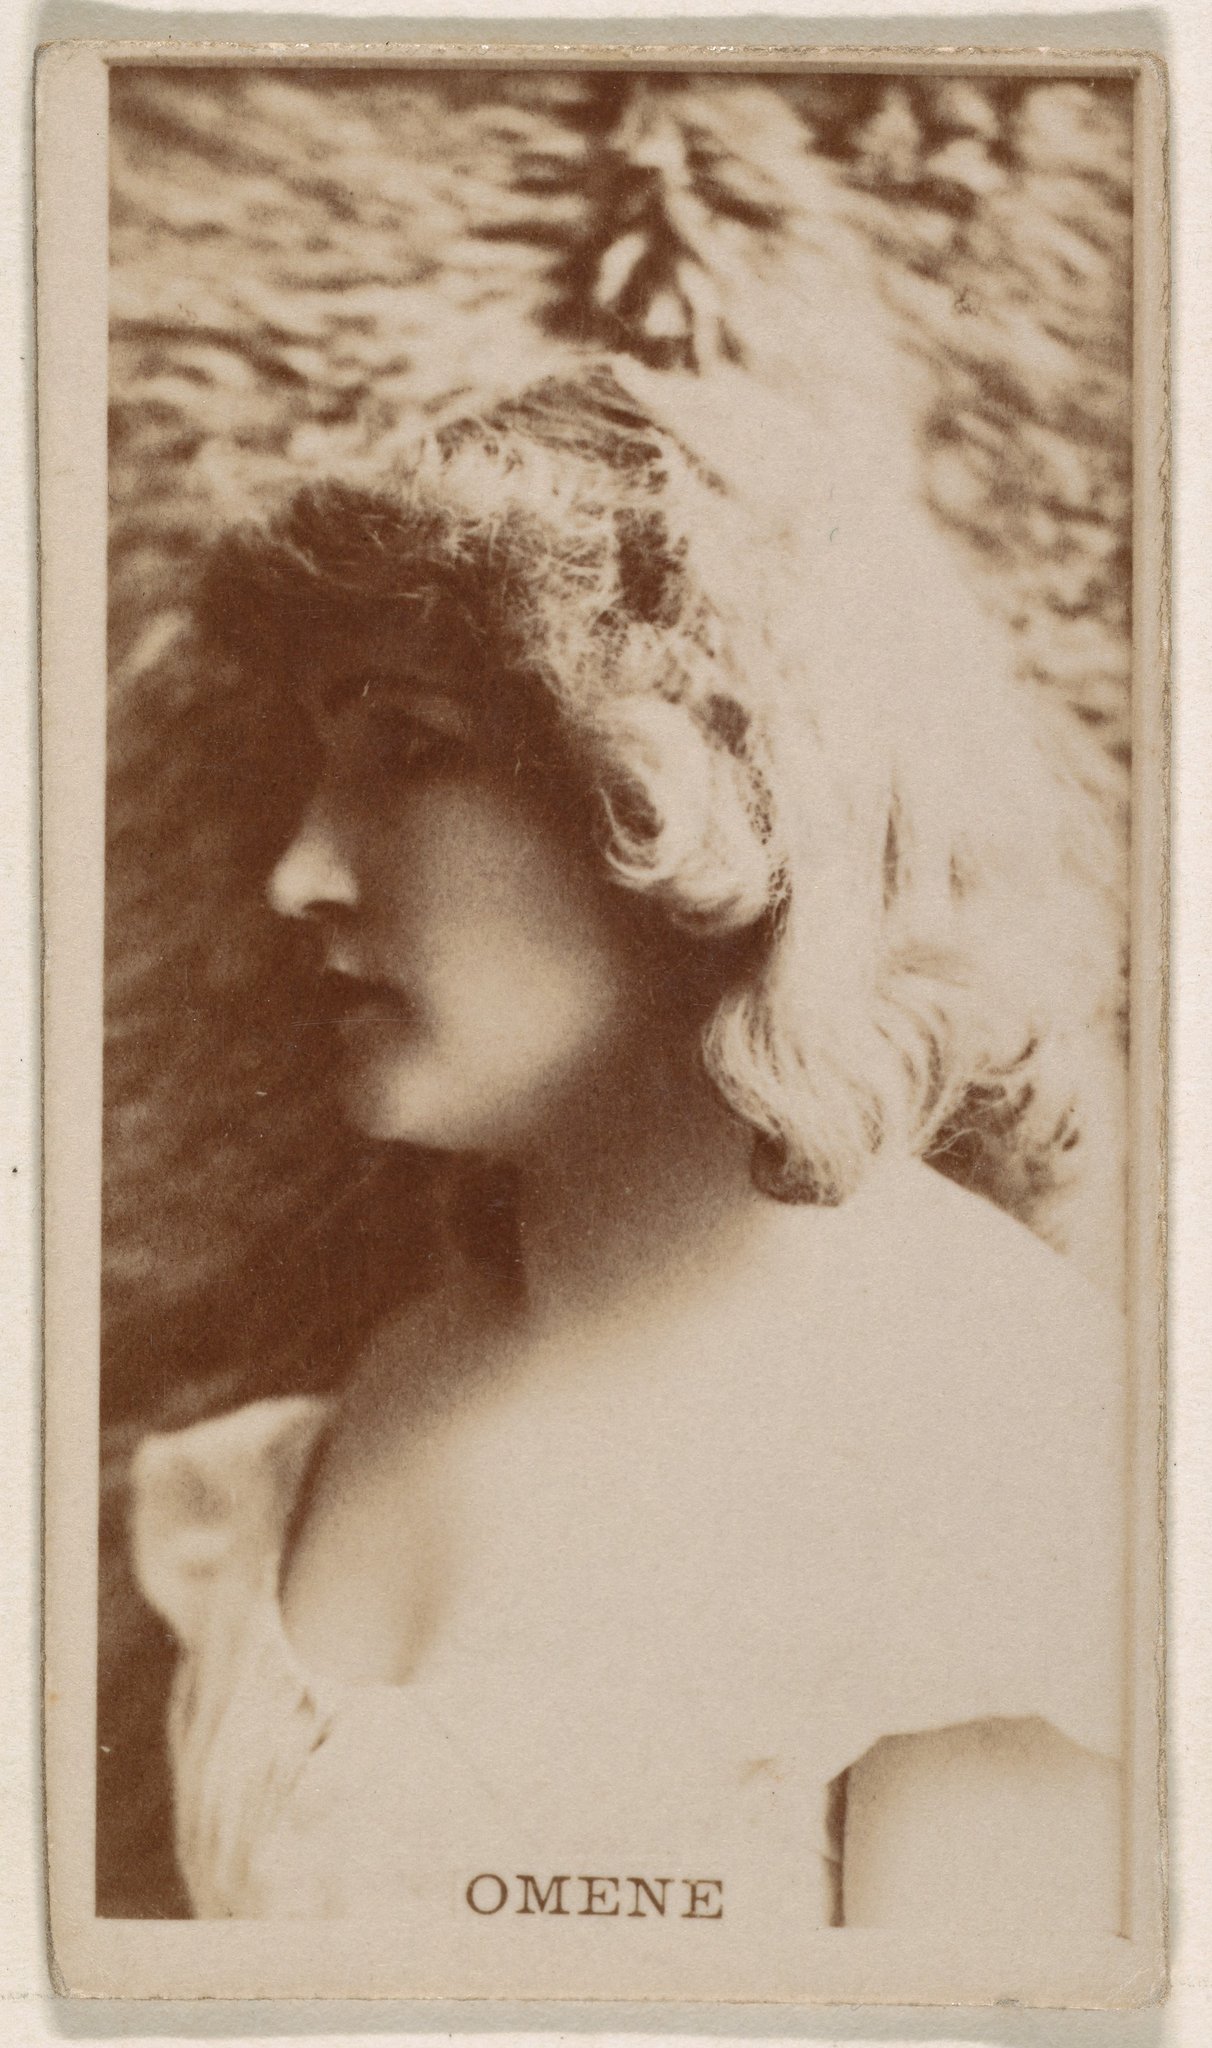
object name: photograph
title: Omene, from the Actresses series (N245) issued by Kinney Brothers to promote Sweet Caporal Cigarettes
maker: kinney brothers tobacco company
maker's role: publisher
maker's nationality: american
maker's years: 1869-2011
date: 1890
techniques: albumen silver print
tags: women,actresses